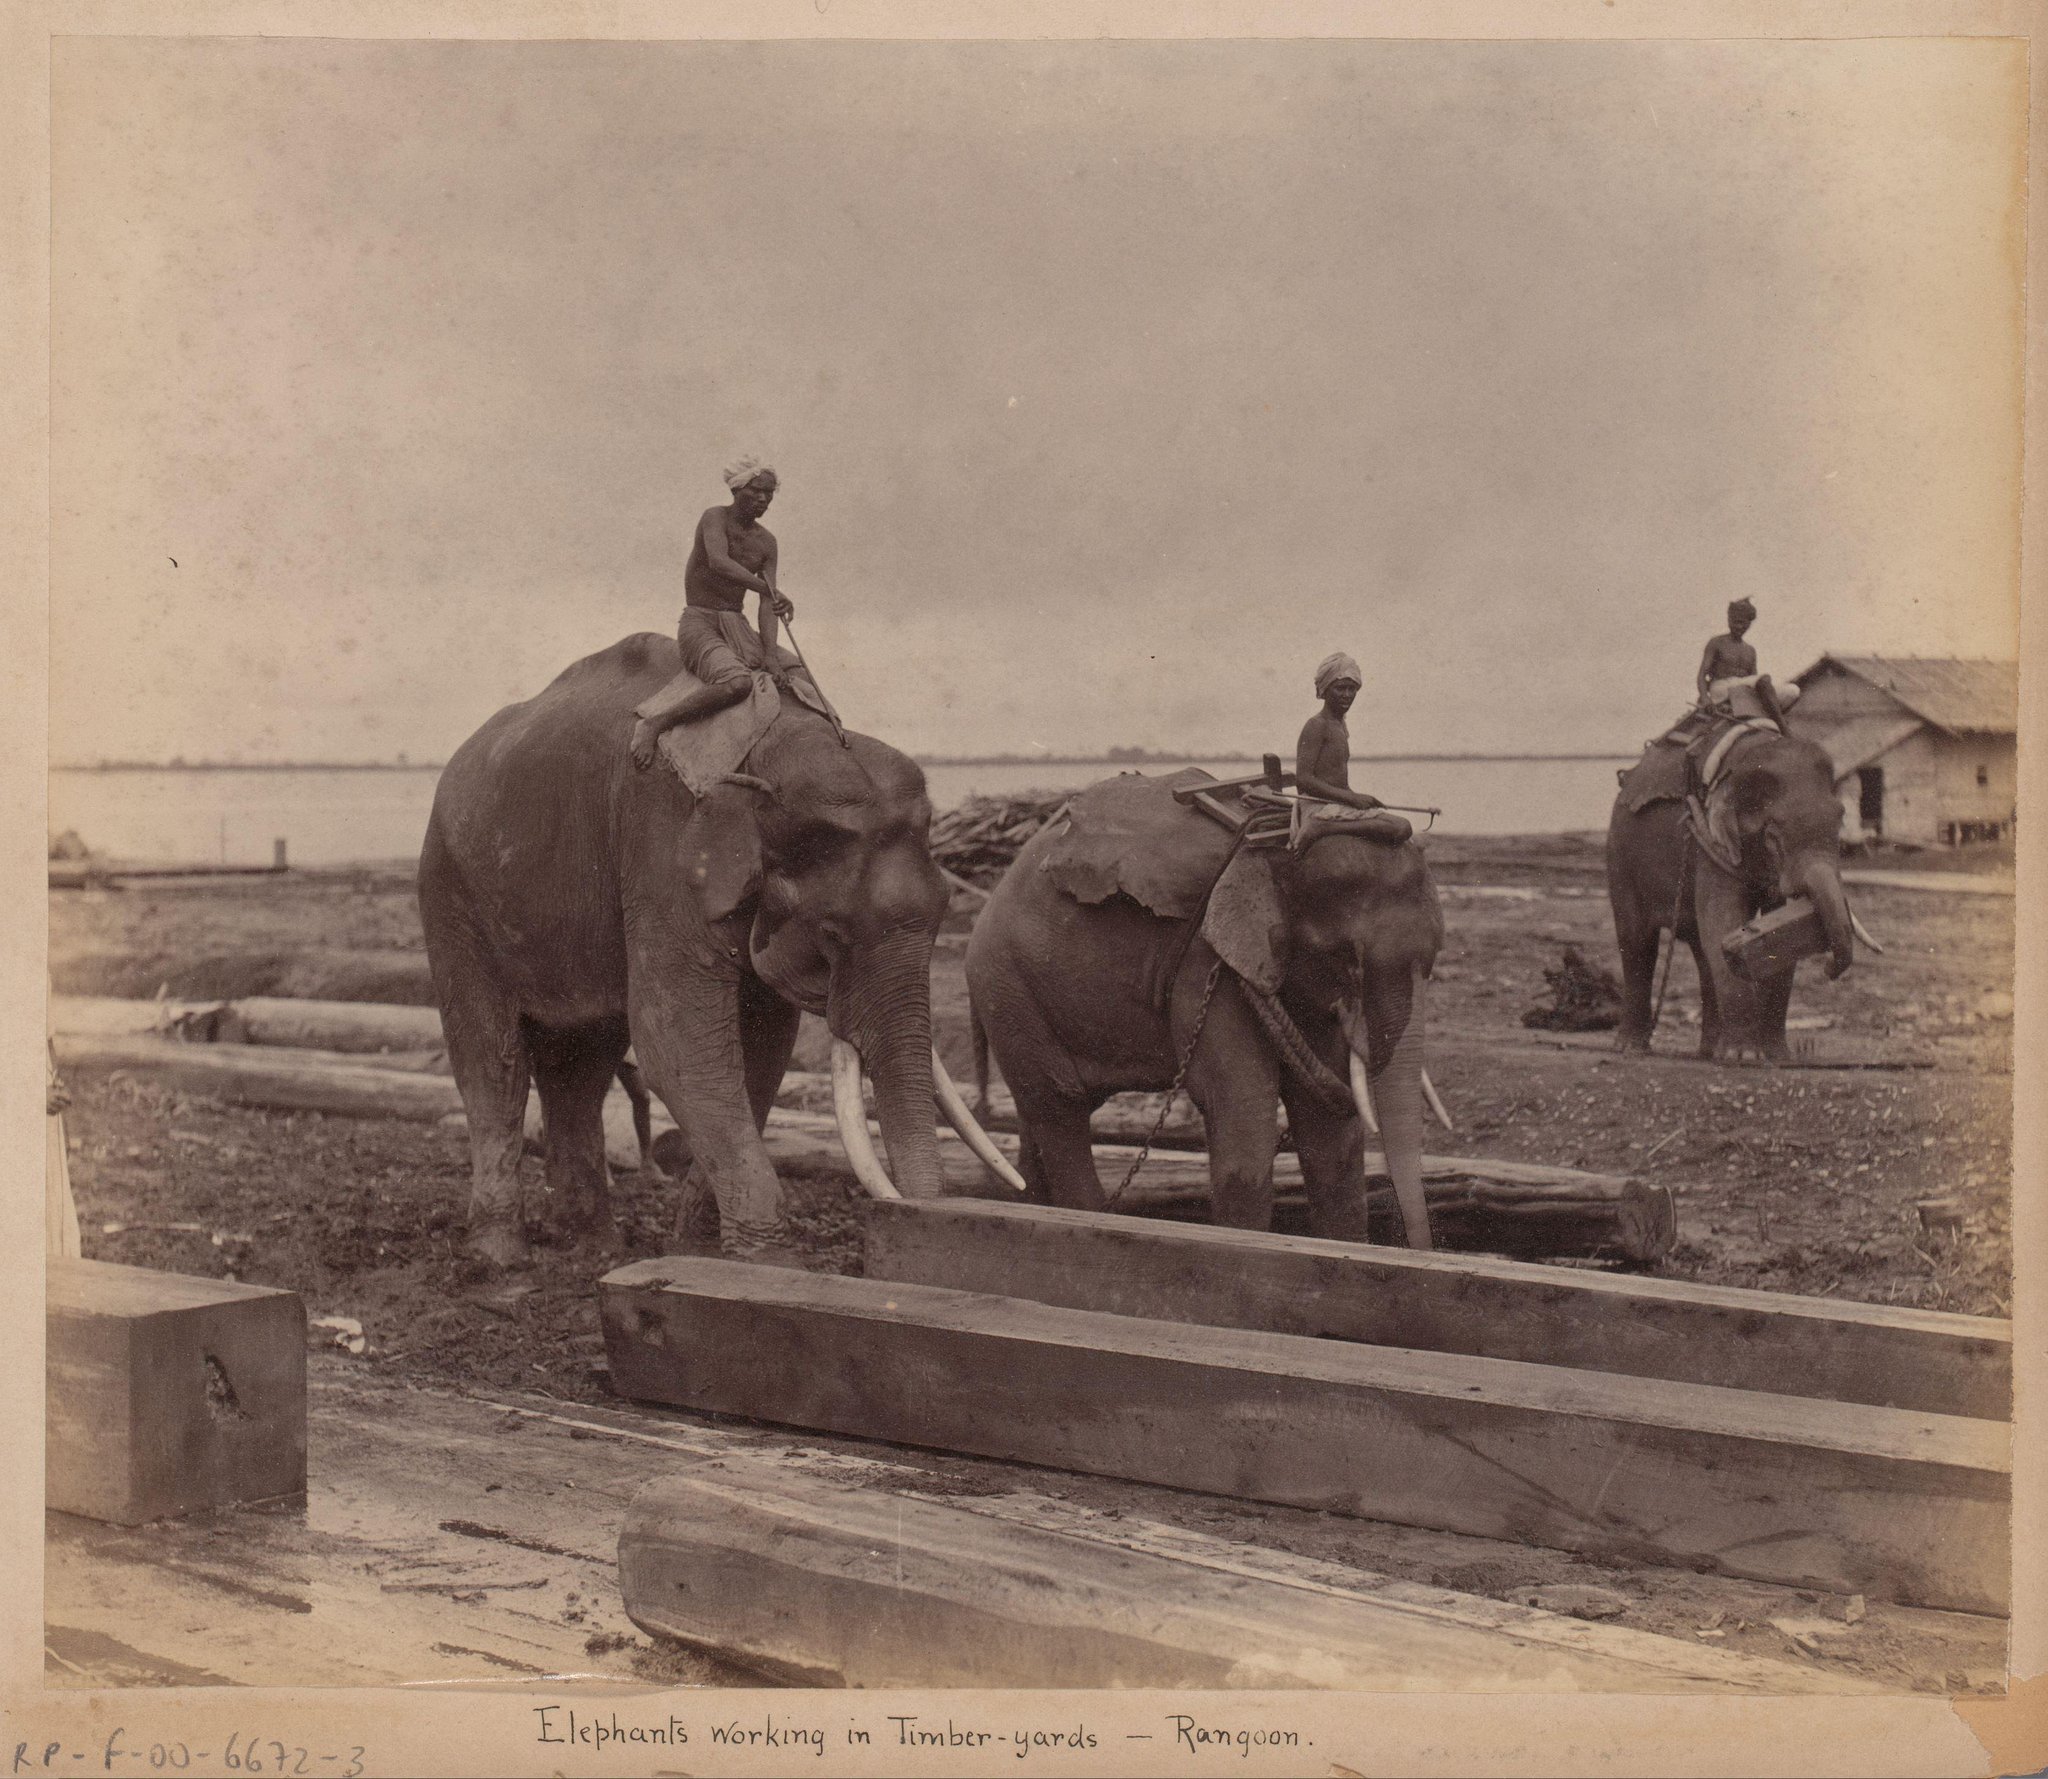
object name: photograph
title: Working elephants in timber yards, Yangon, Myanmar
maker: Anonymous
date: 1870-1900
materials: cardboard, paper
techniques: albumen print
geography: yangon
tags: yangon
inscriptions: inscription: ‘Elephants’, caption: ‘Elephants working in Timber-yards - Rangoon.’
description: Drie werkende olifanten in een timmerwerkplaats, Rangoon, unie van Myanmar (vroeger Birma).